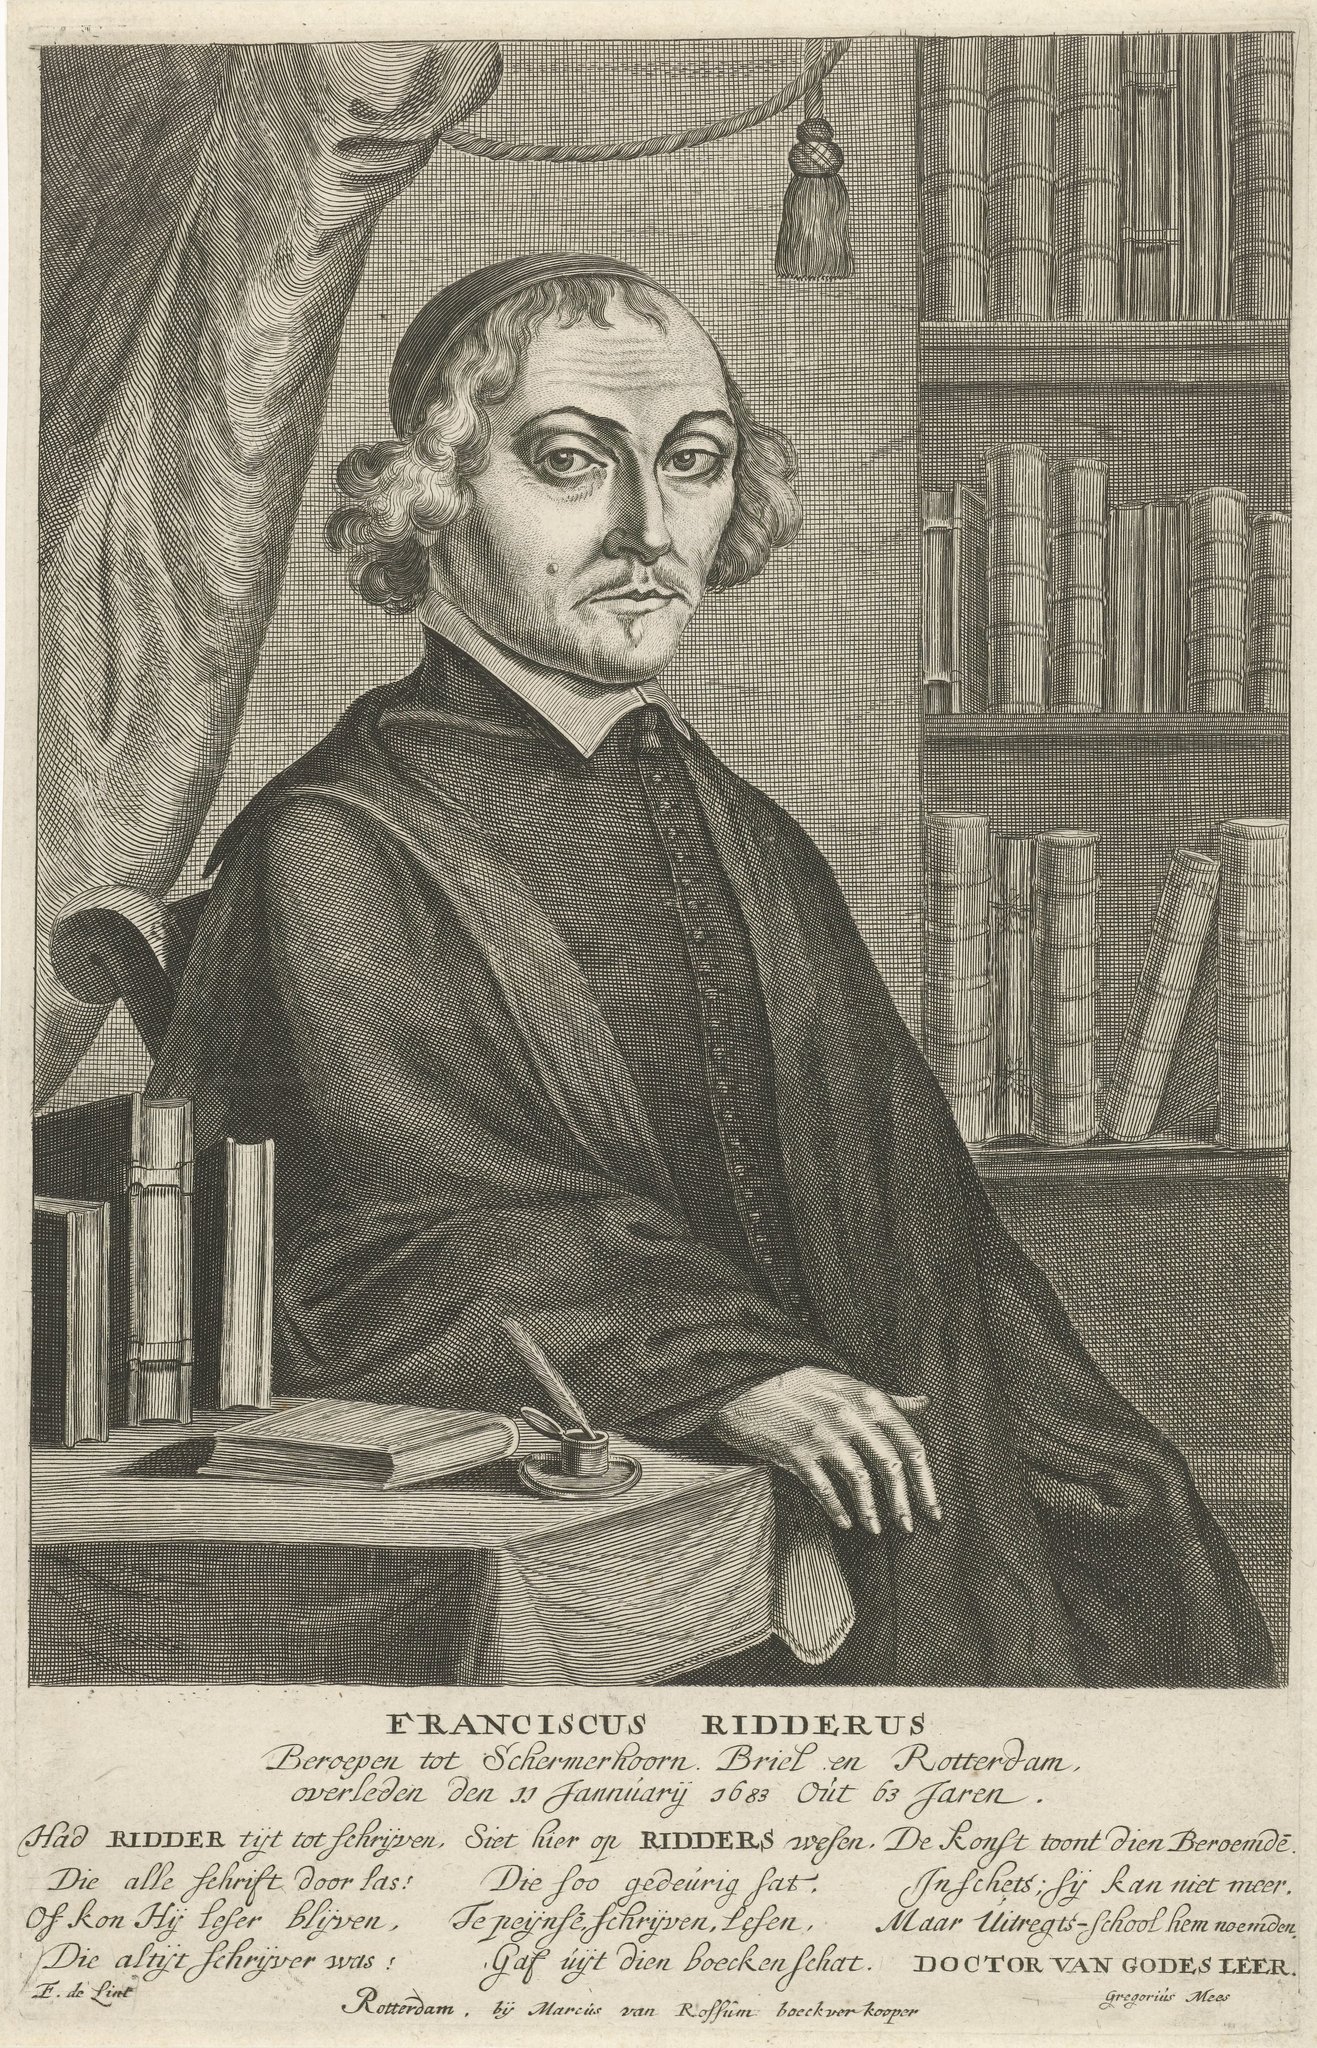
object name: print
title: Portret van Franciscus Ridderus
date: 1658-1725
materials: paper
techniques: engraving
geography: netherlands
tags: leiden, writing tools, book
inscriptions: collector's mark: Lugt 2228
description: Franciscus Ridderus, predikant, staand bij een tafel met boeken en schrijfgerei. Op de achtergrond een boekenkast. Portret ten halven lijve naar rechts. Onderaan in de marge twee vierregelige verzen en een drieregelig vers in het Nederlands.